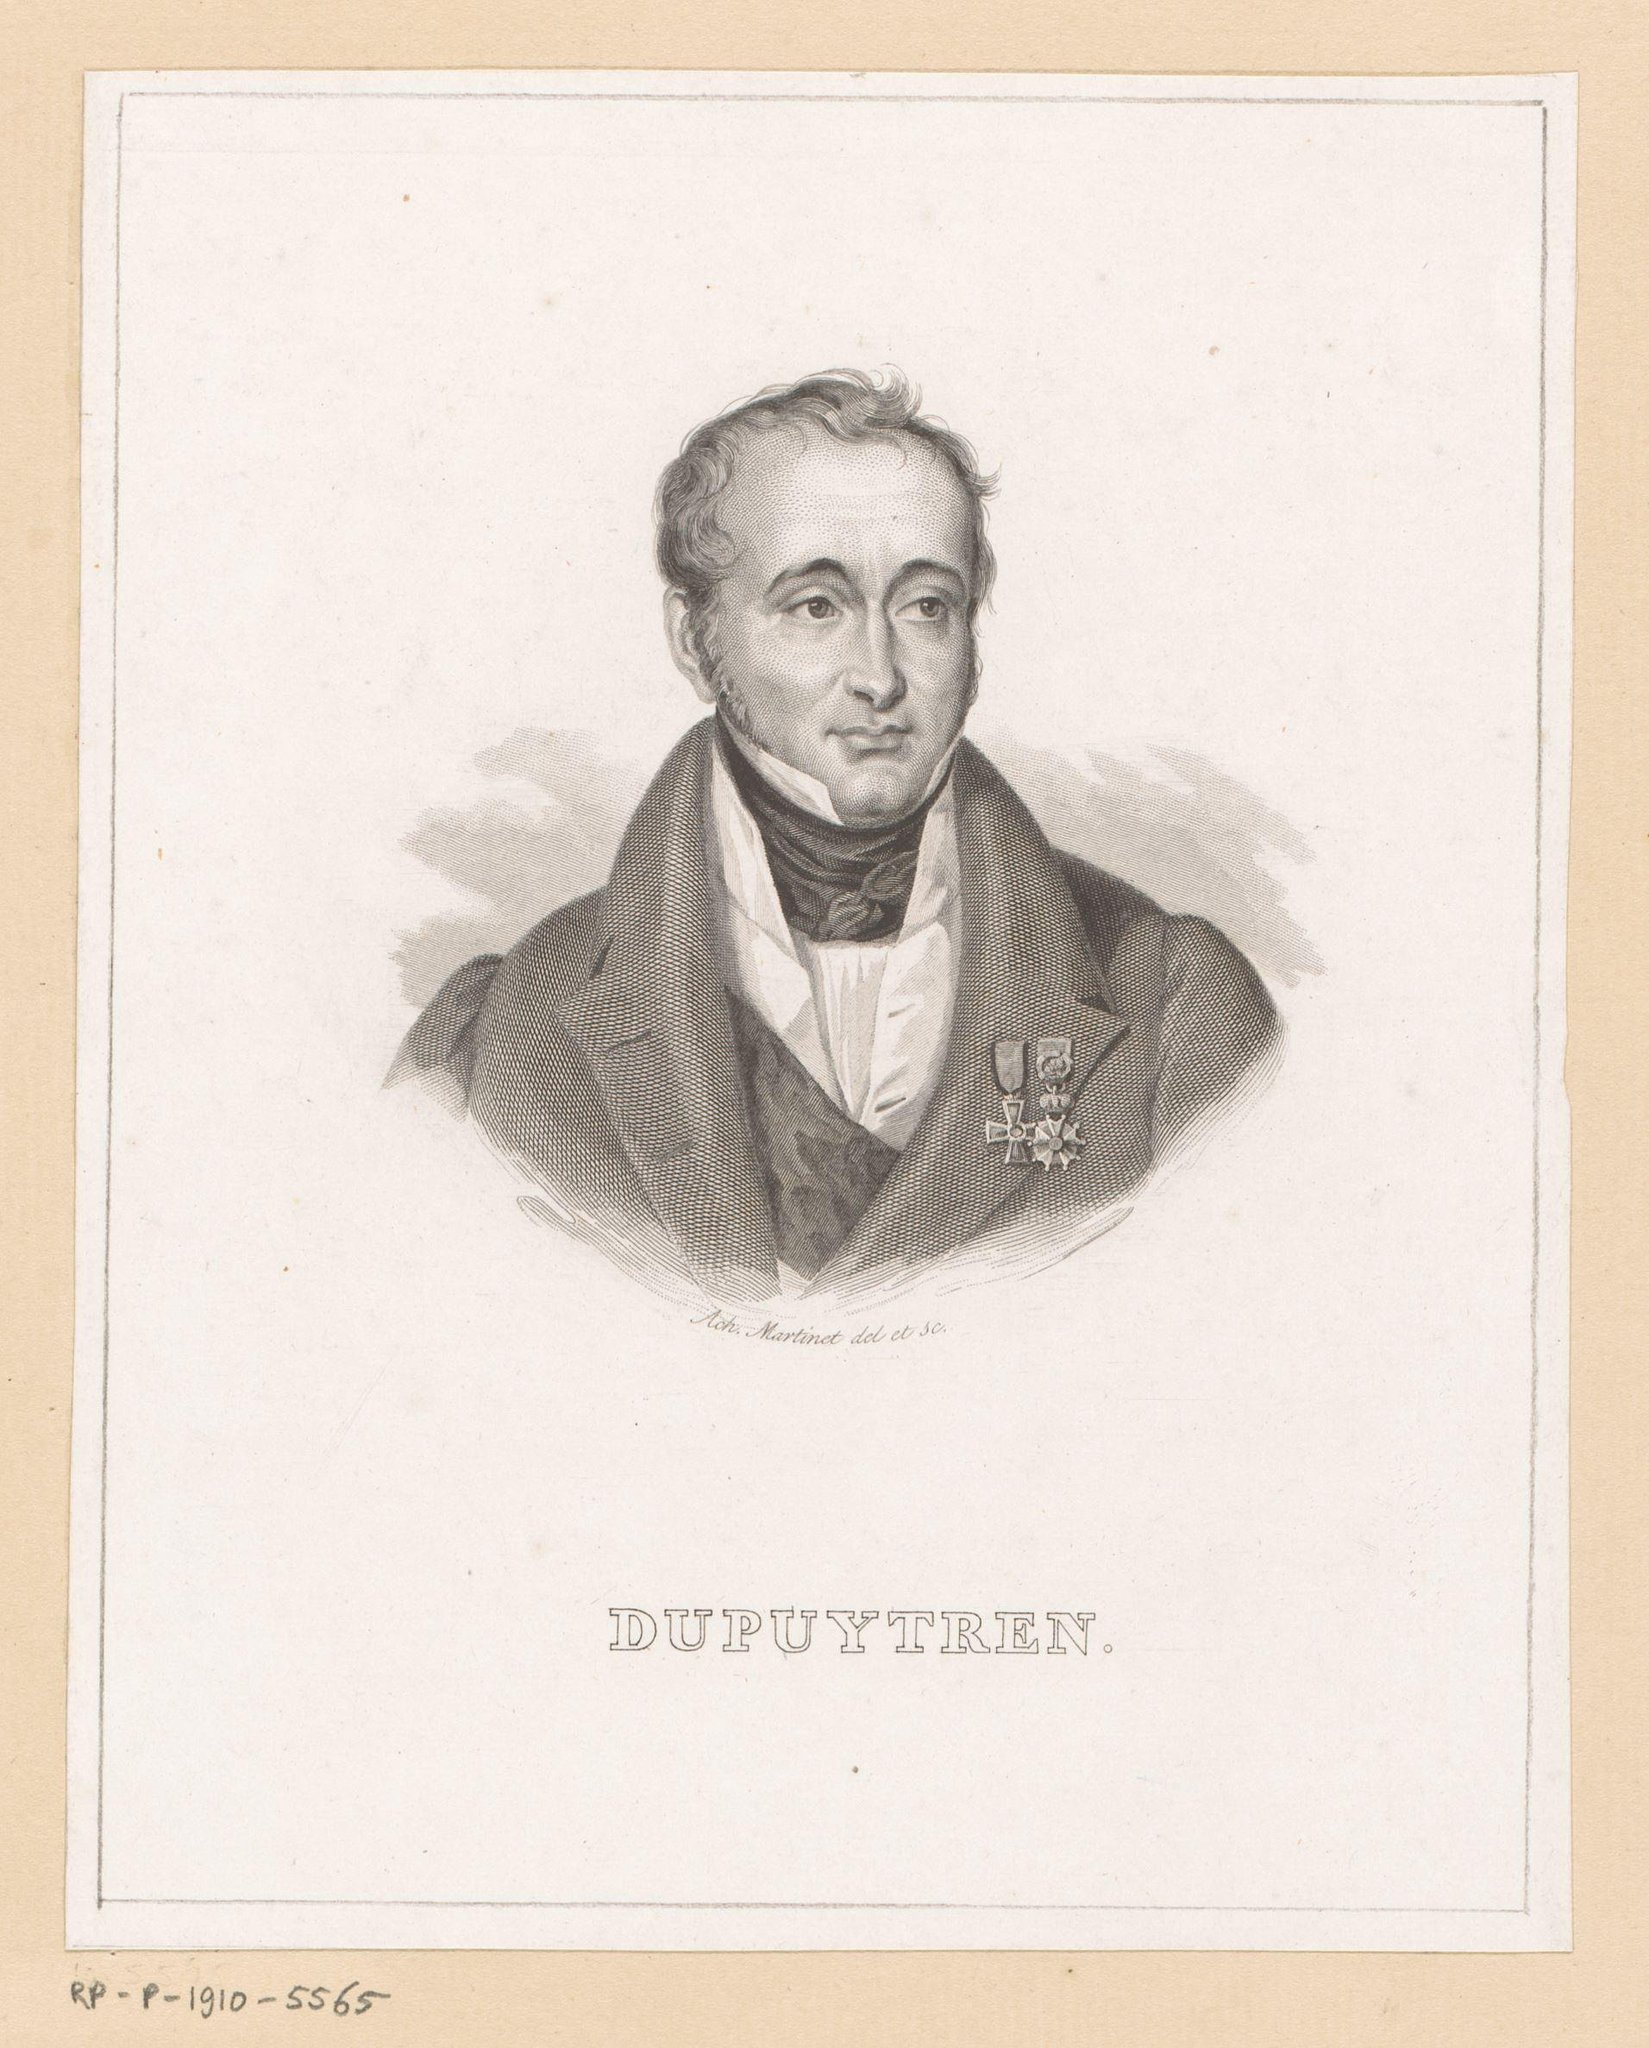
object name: print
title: Portret van Guillaume Dupuytren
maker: achille louis martinet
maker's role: print maker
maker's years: 1806-1877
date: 1816-1877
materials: paper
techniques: engraving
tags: historical persons, barber; surgeon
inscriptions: collector's mark: Lugt 2228